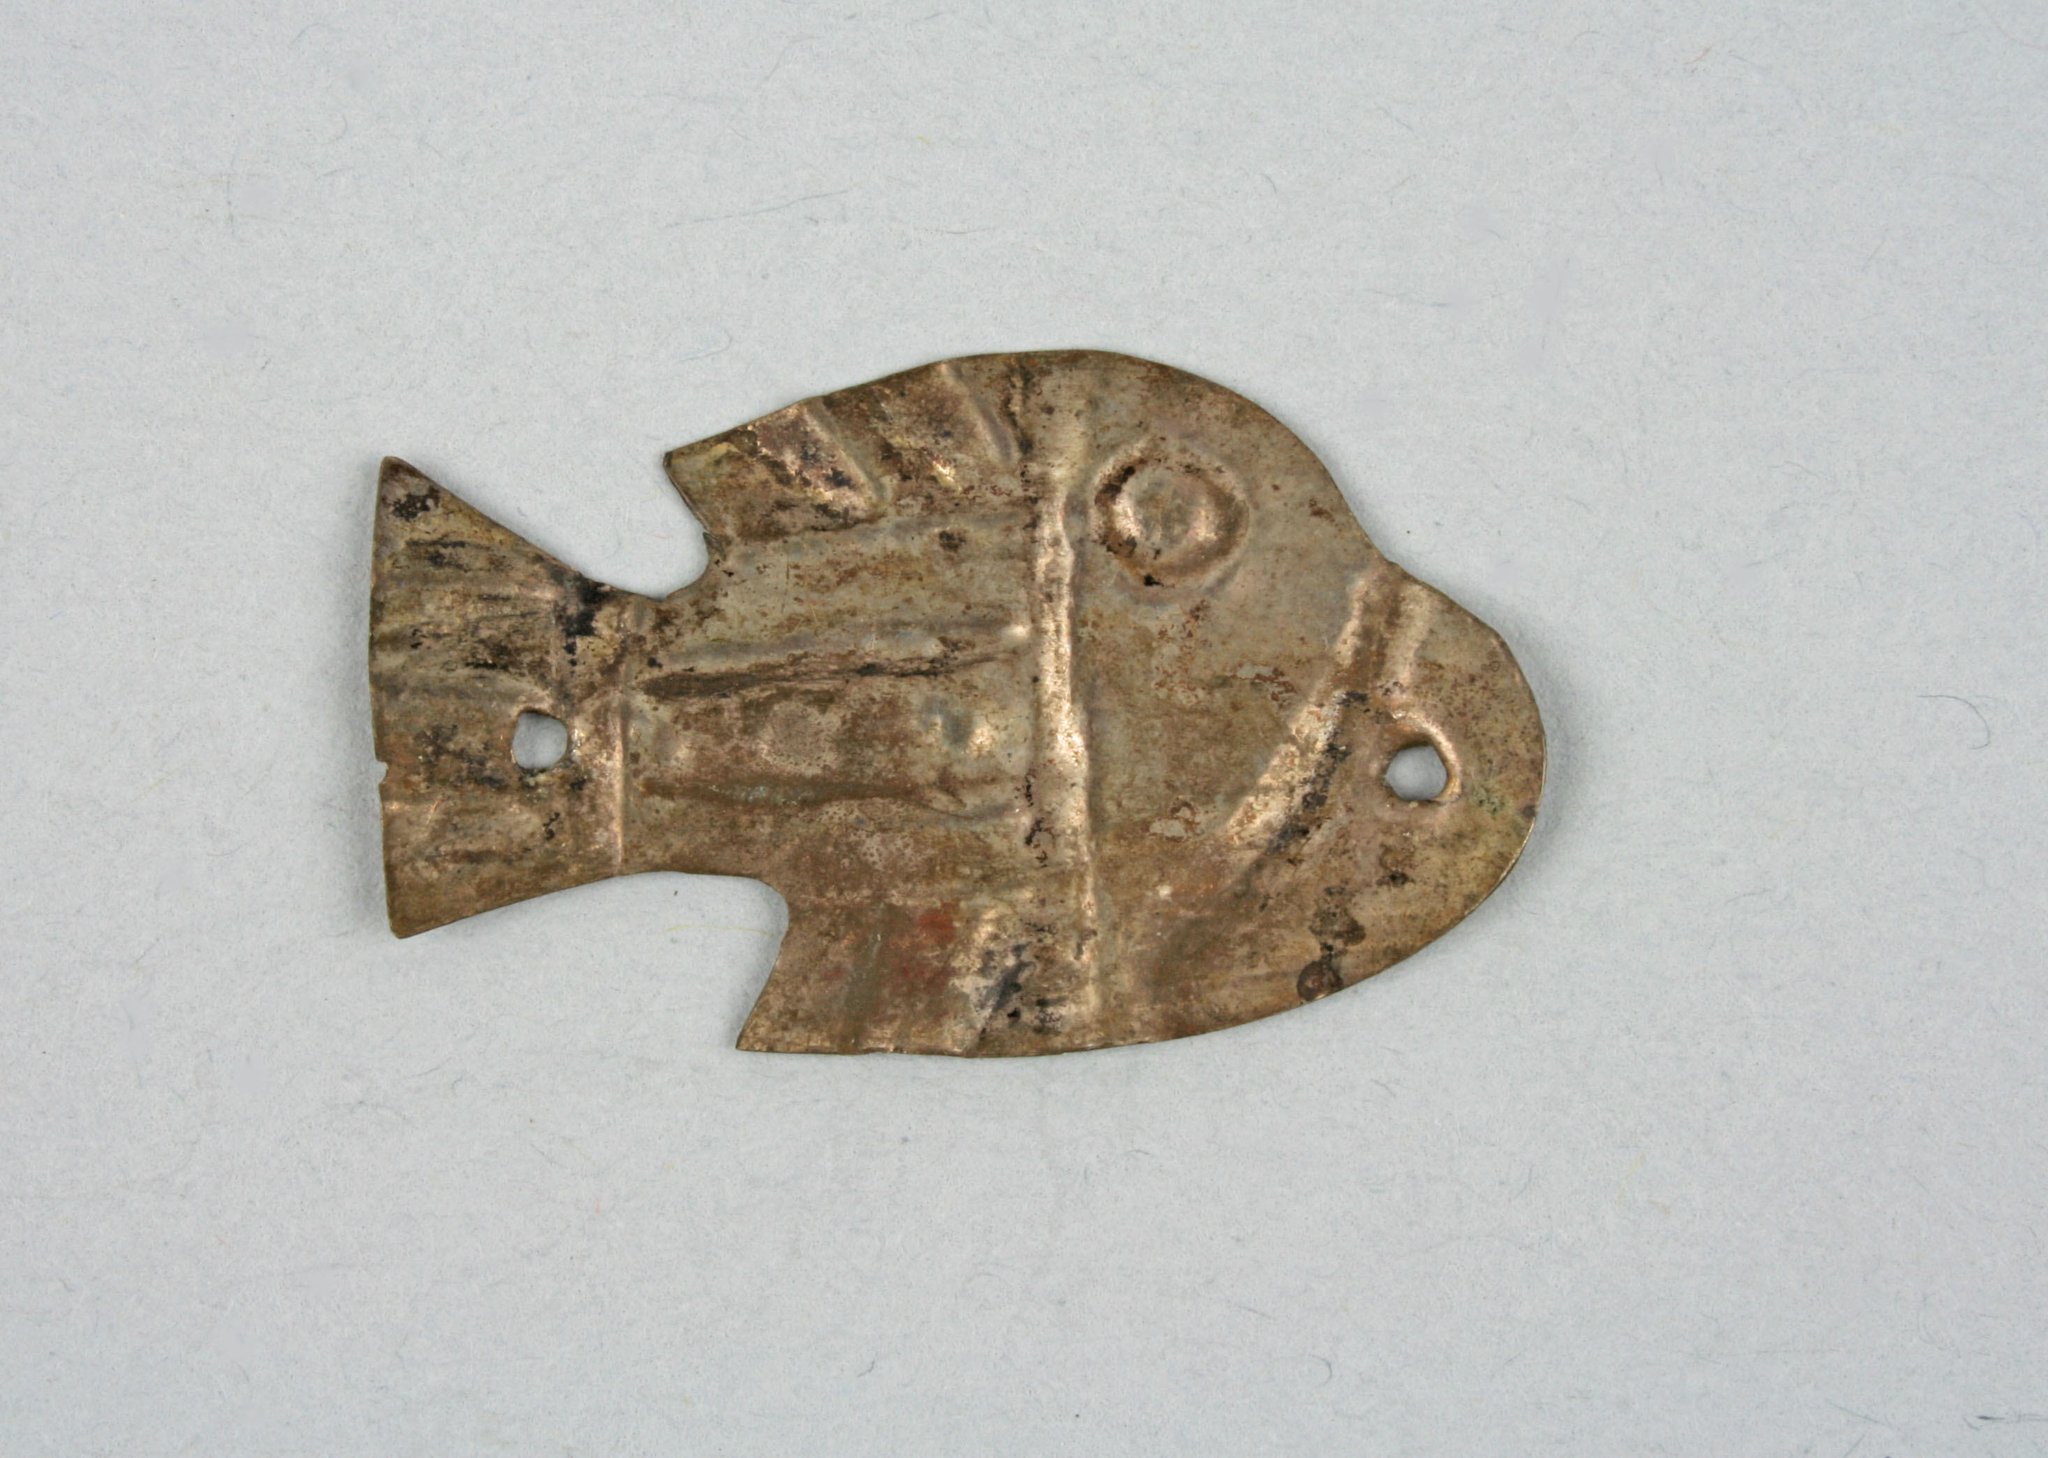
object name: costume ornament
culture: central coast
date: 1001-1200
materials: silver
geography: peru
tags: fish